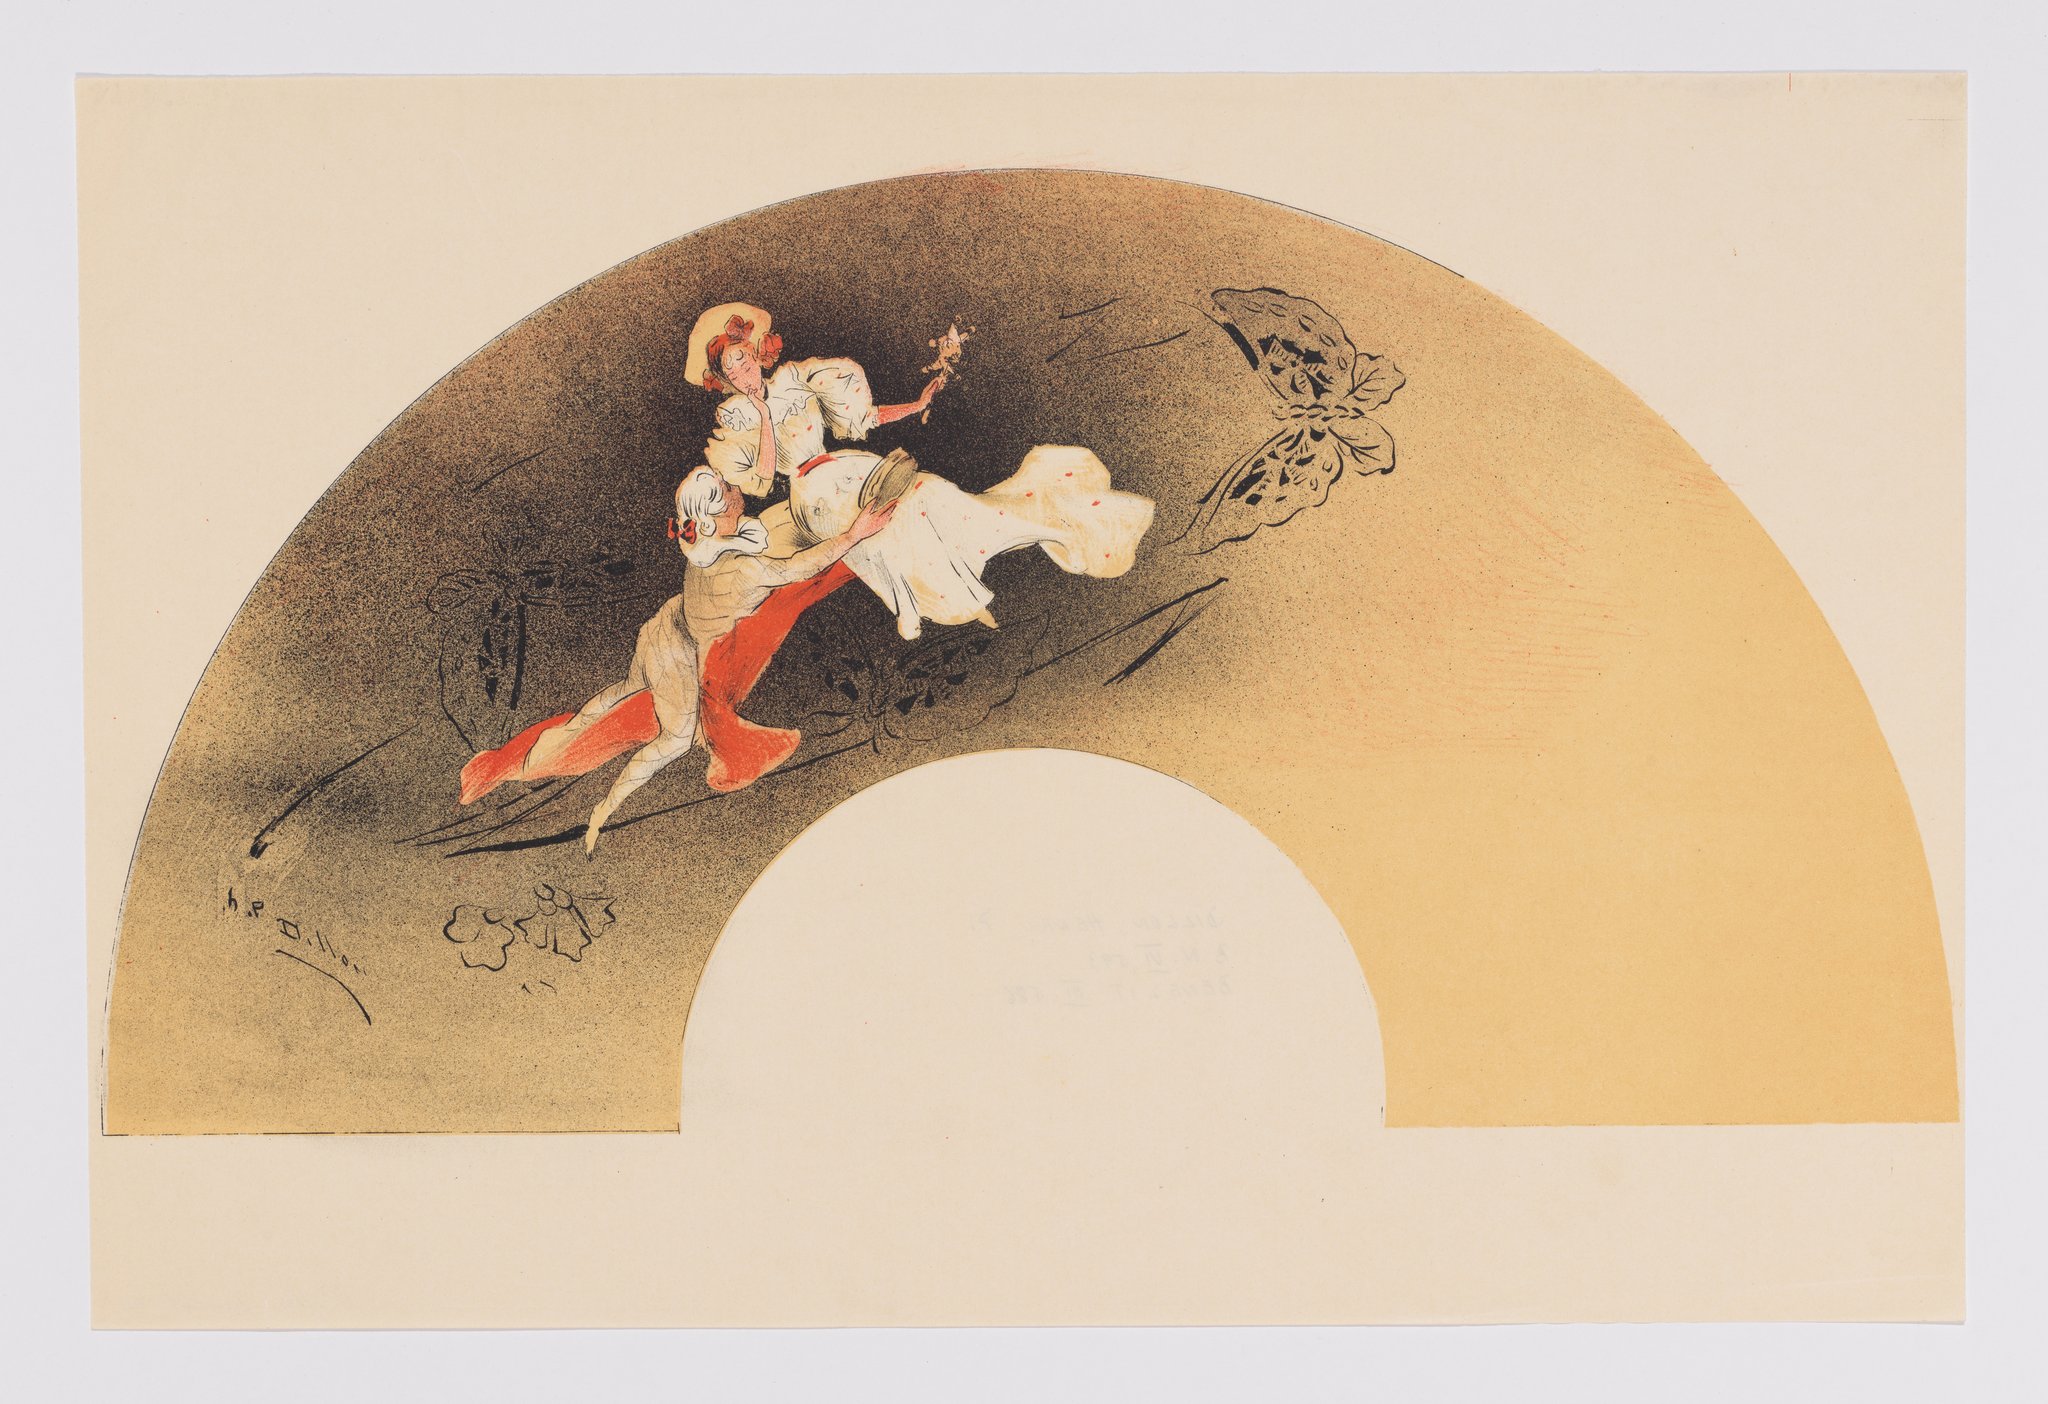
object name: print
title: Fan leaf depicting a couple and butterflies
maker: henri patrice dillon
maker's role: artist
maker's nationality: french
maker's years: 1851-1909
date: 1904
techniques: lithograph, printing